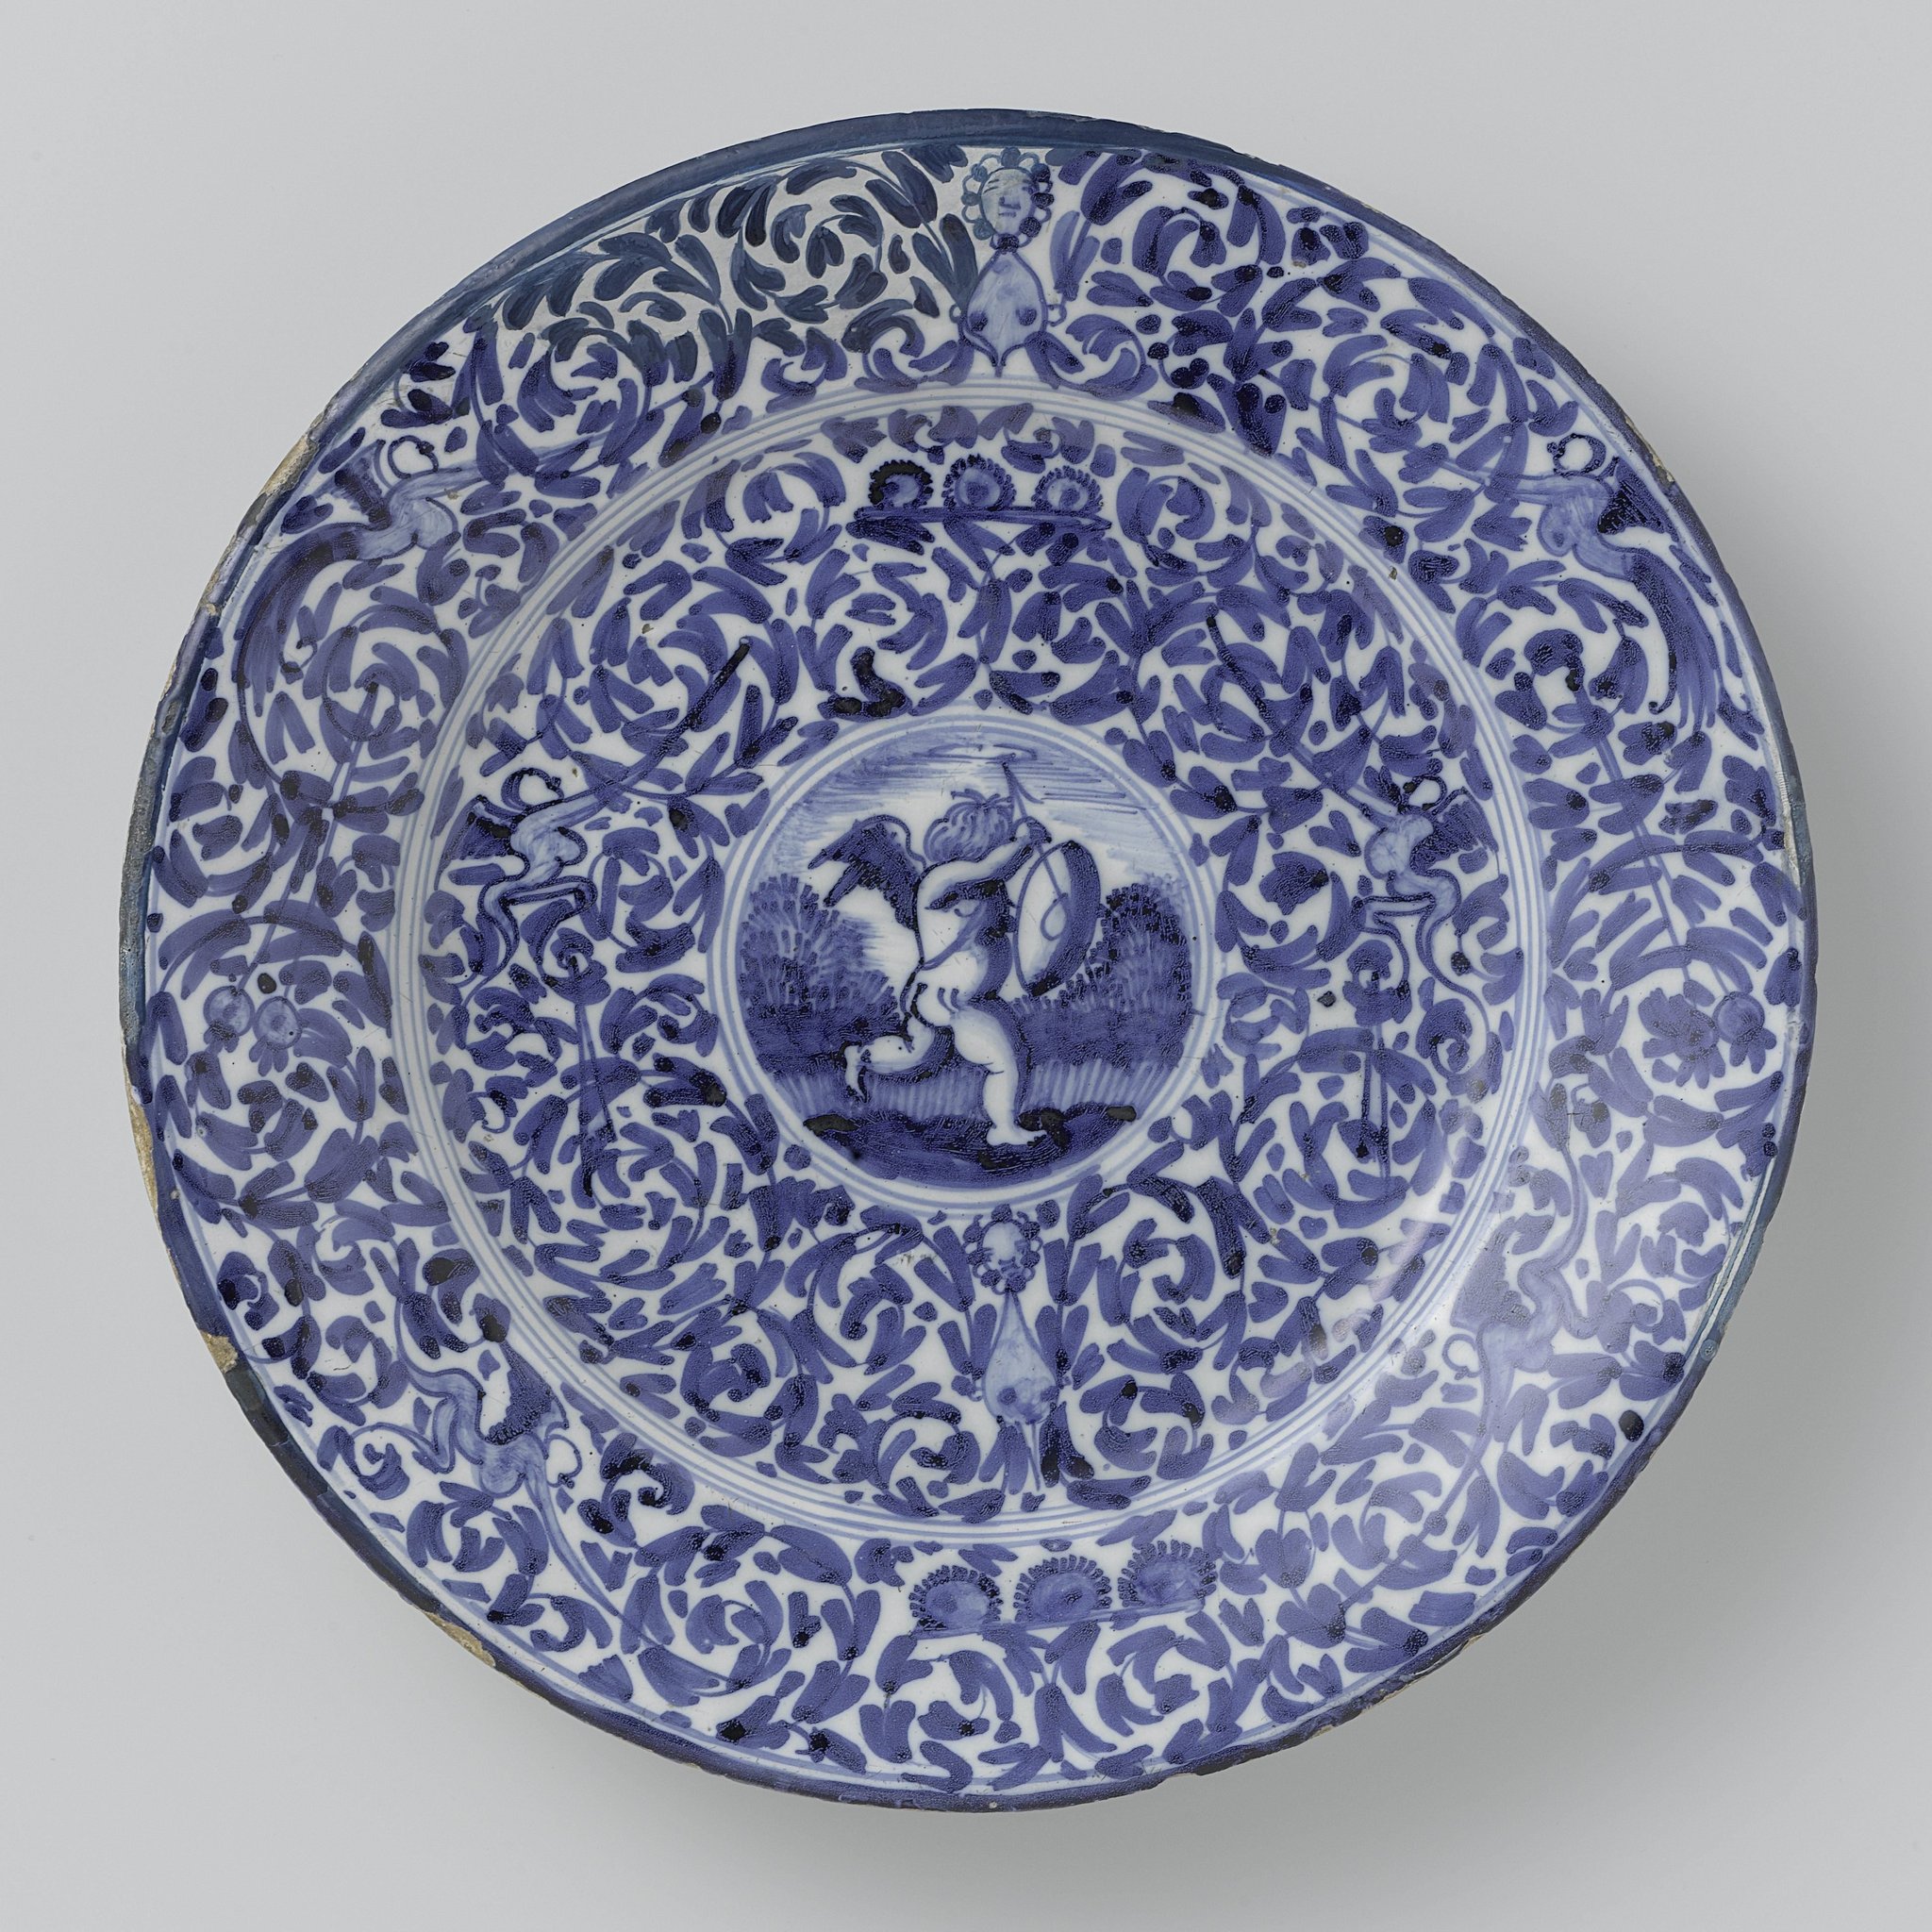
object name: platter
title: Schotel van faience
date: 1655-1670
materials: faience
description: Schotel van faience. Blauw beschilderd met in het midden een medaillon met een putto, daar omheen 2 banden met bladranken.